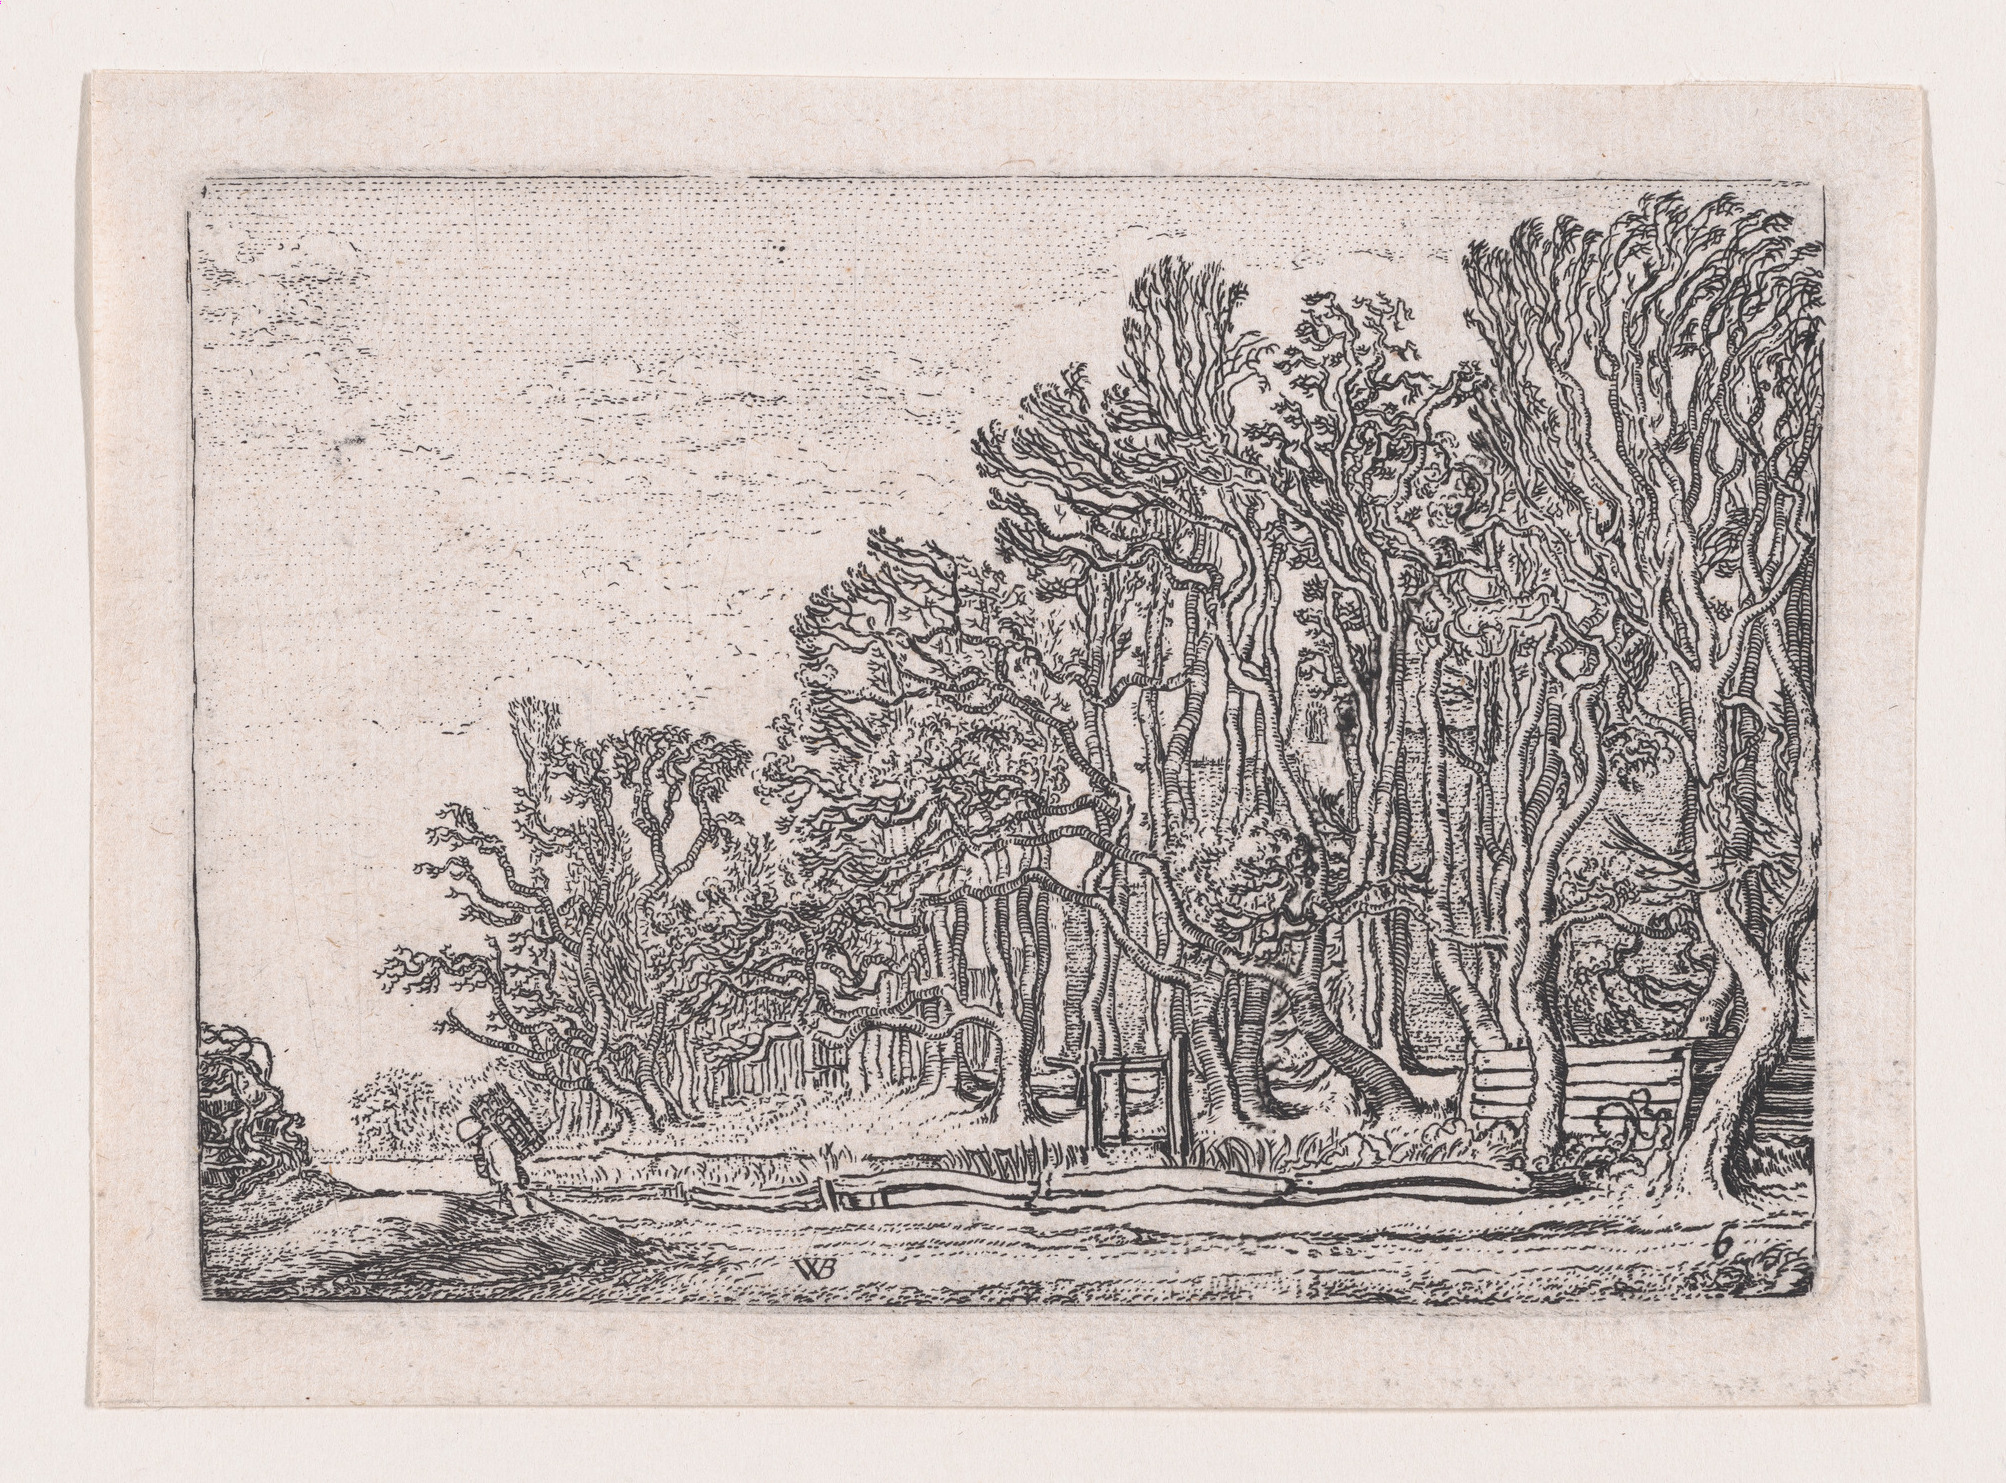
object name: print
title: Two Plank Hedges, from Verscheyden Landtschapjes (Various Little Landscapes), Plate 6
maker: willem pietersz buytewech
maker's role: artist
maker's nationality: dutch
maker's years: 1591-1624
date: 1616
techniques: etching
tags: trees